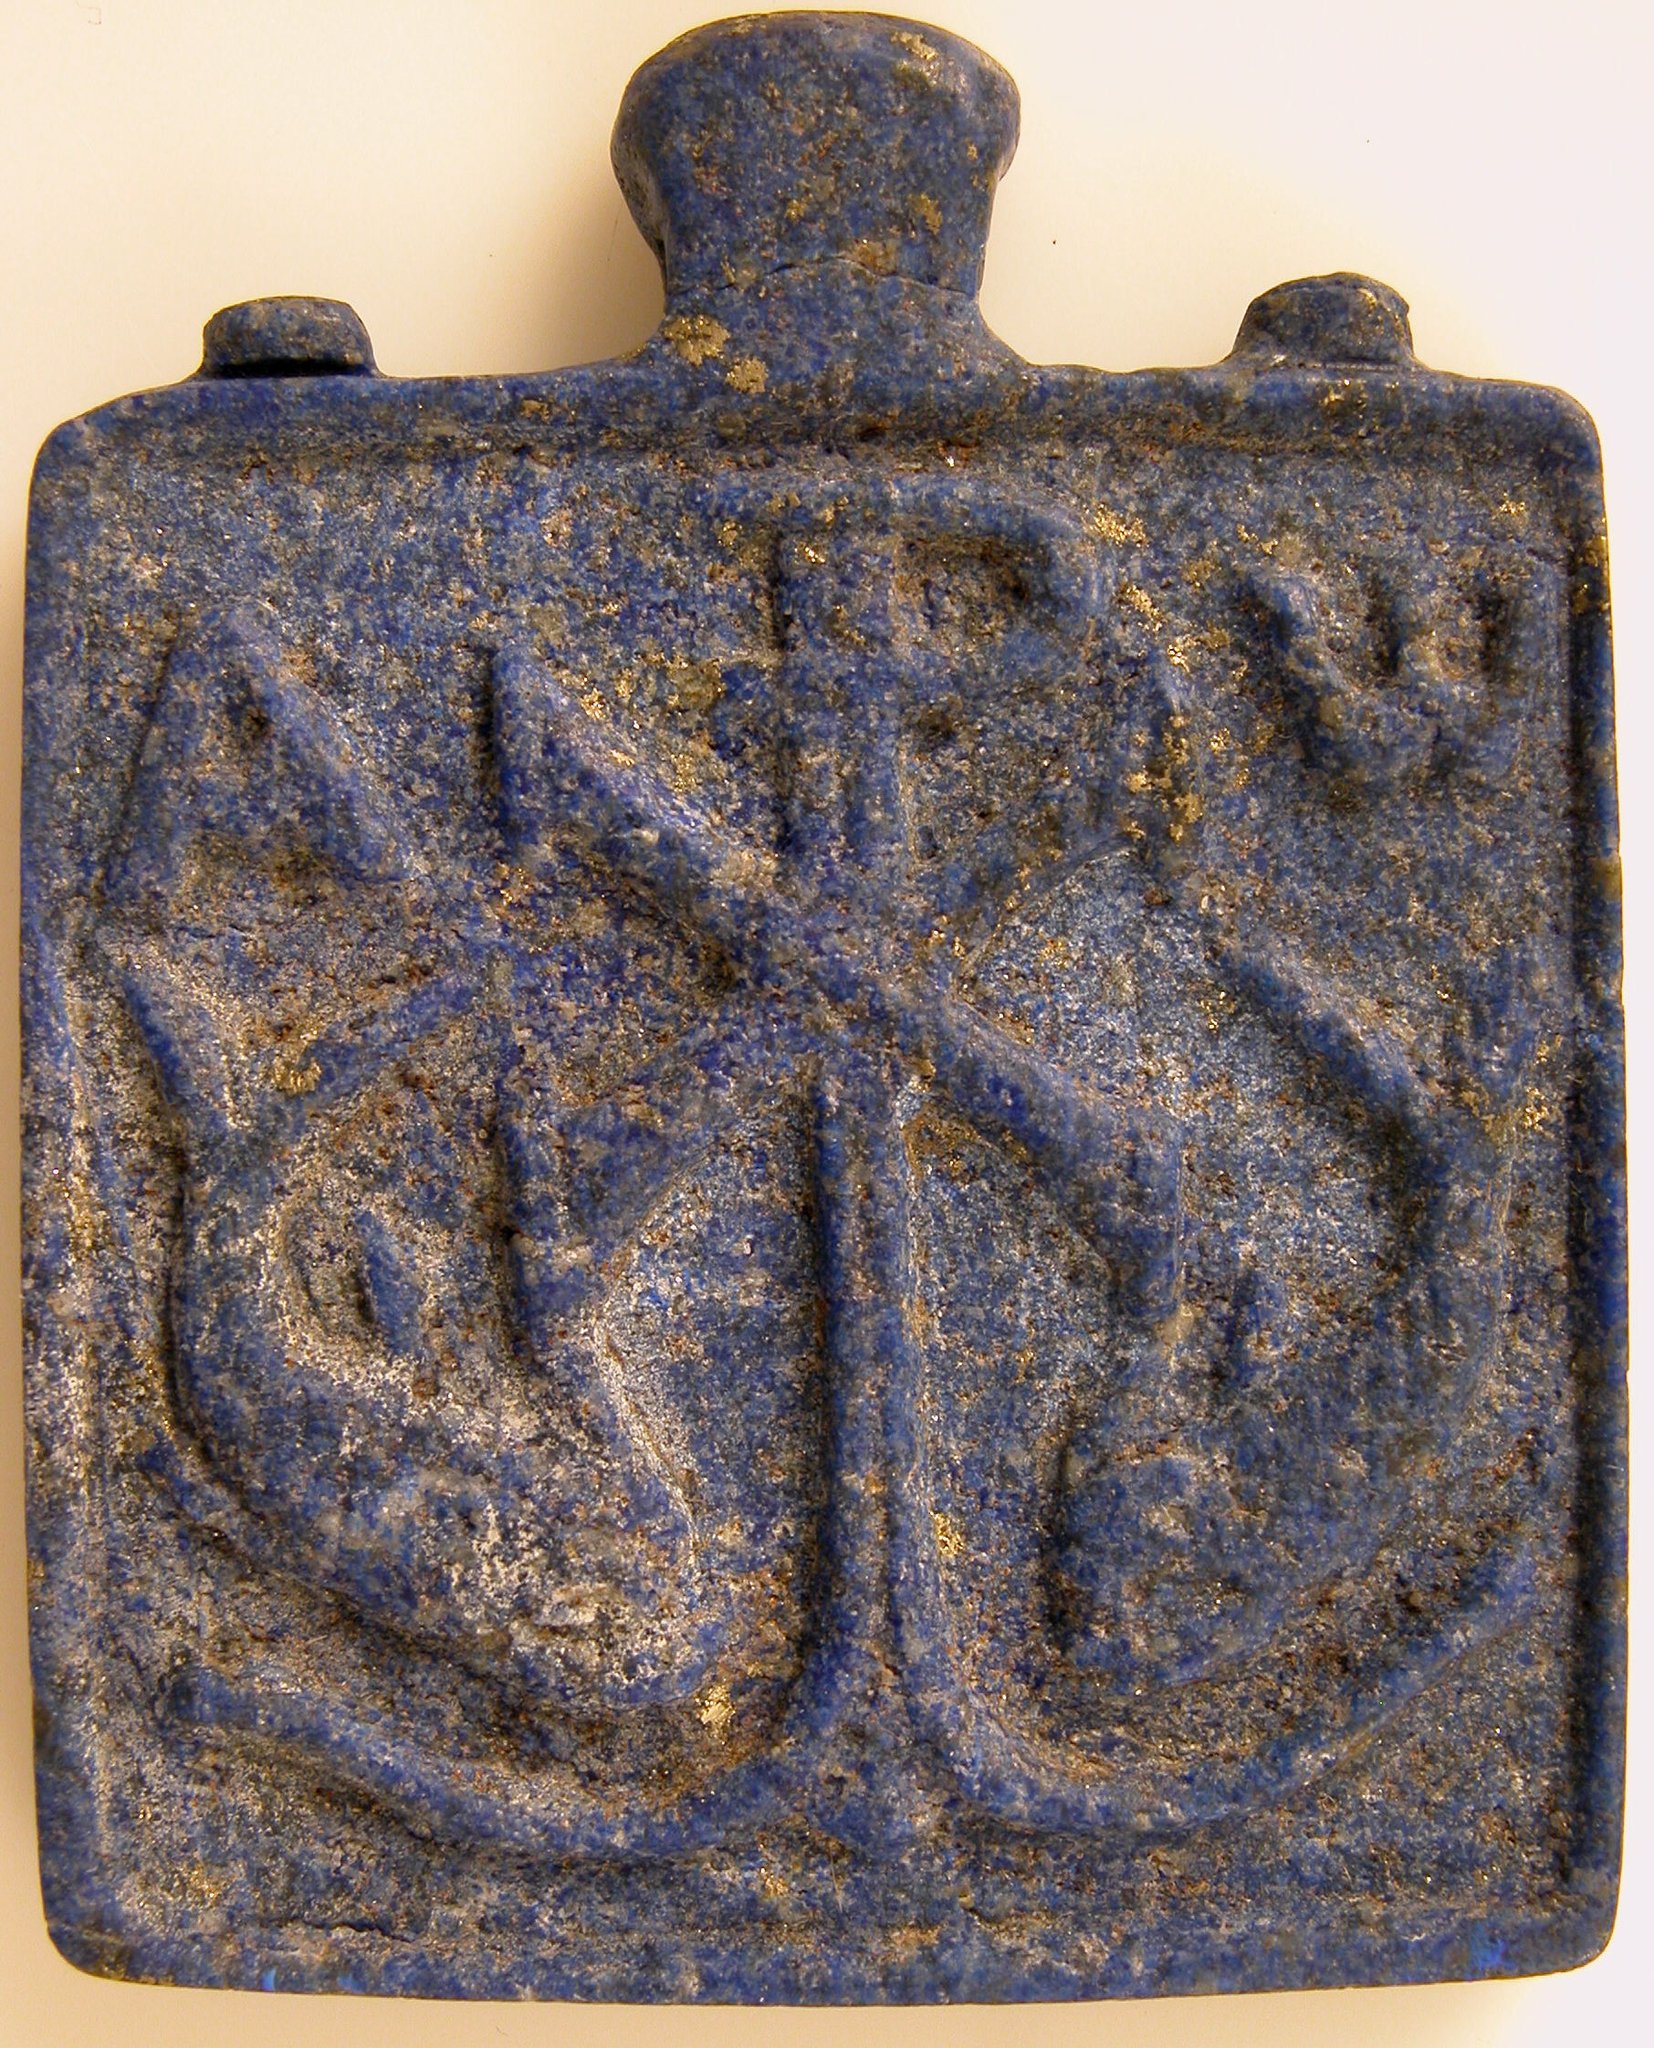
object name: pendant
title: Pendant Plaque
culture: byzantine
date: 301-500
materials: lapis lazuli